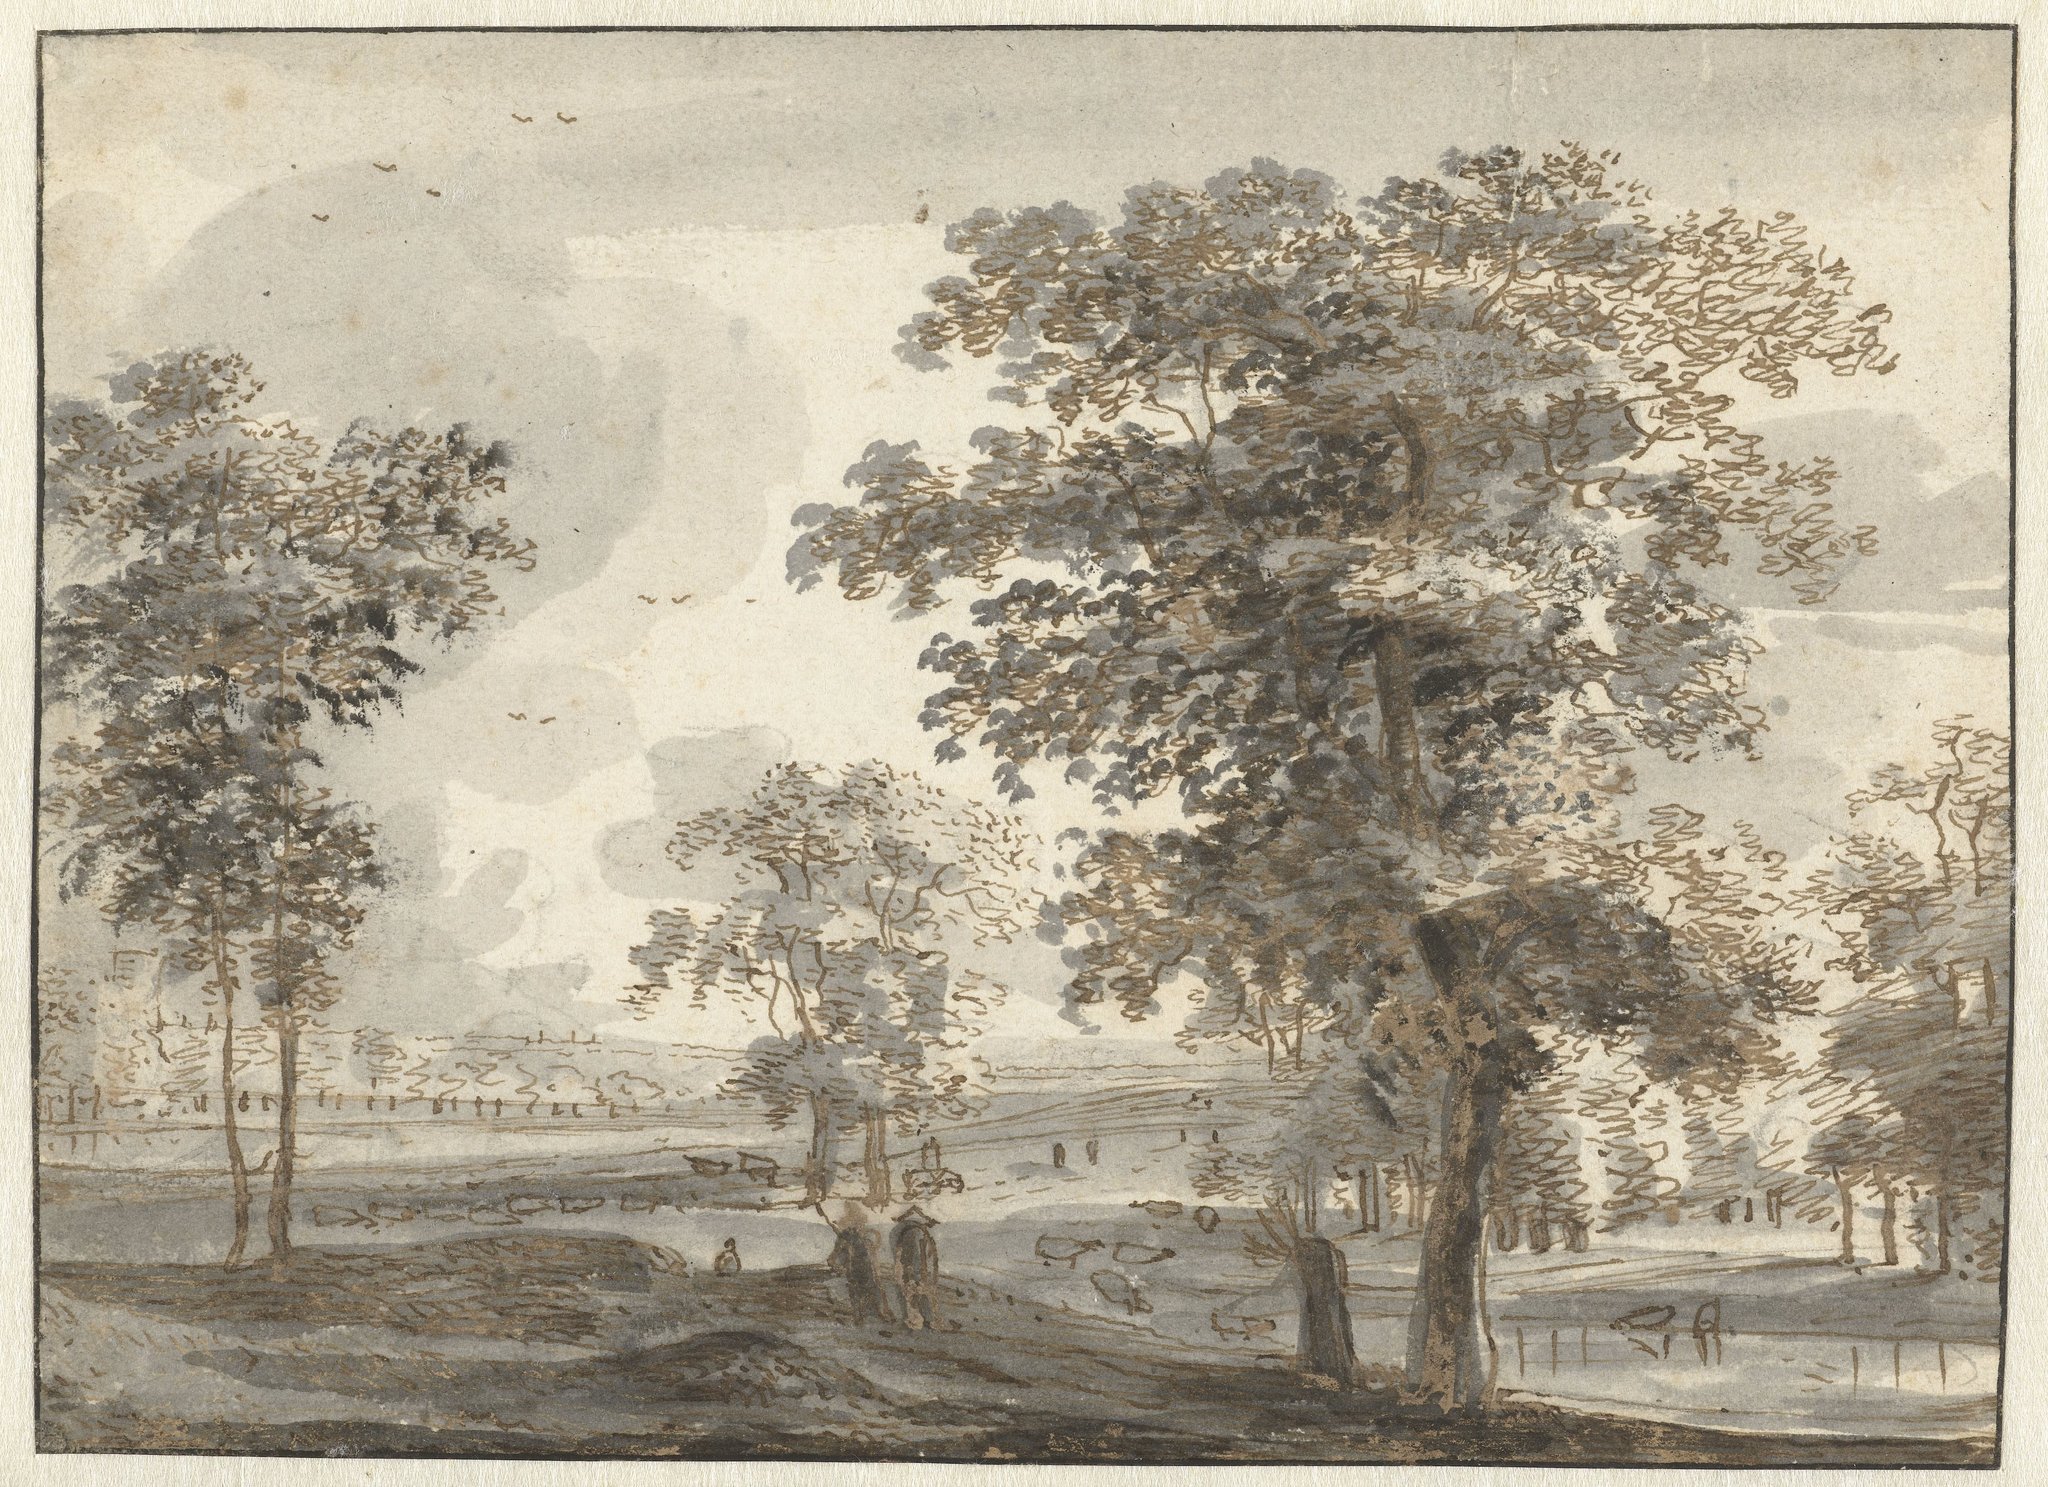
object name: drawing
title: Wooded Landscape with Herdsmen near a River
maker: roelant roghman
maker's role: draughtsman, painter, print maker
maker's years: 1627-1692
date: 1657-1670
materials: chalk, ink, paper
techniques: brush, pen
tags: herding, herdsman, herdswoman, shepherd, shepherdess, cowherd, etc., landscapes with waters, waterscapes, seascapes (in the temperate zone)